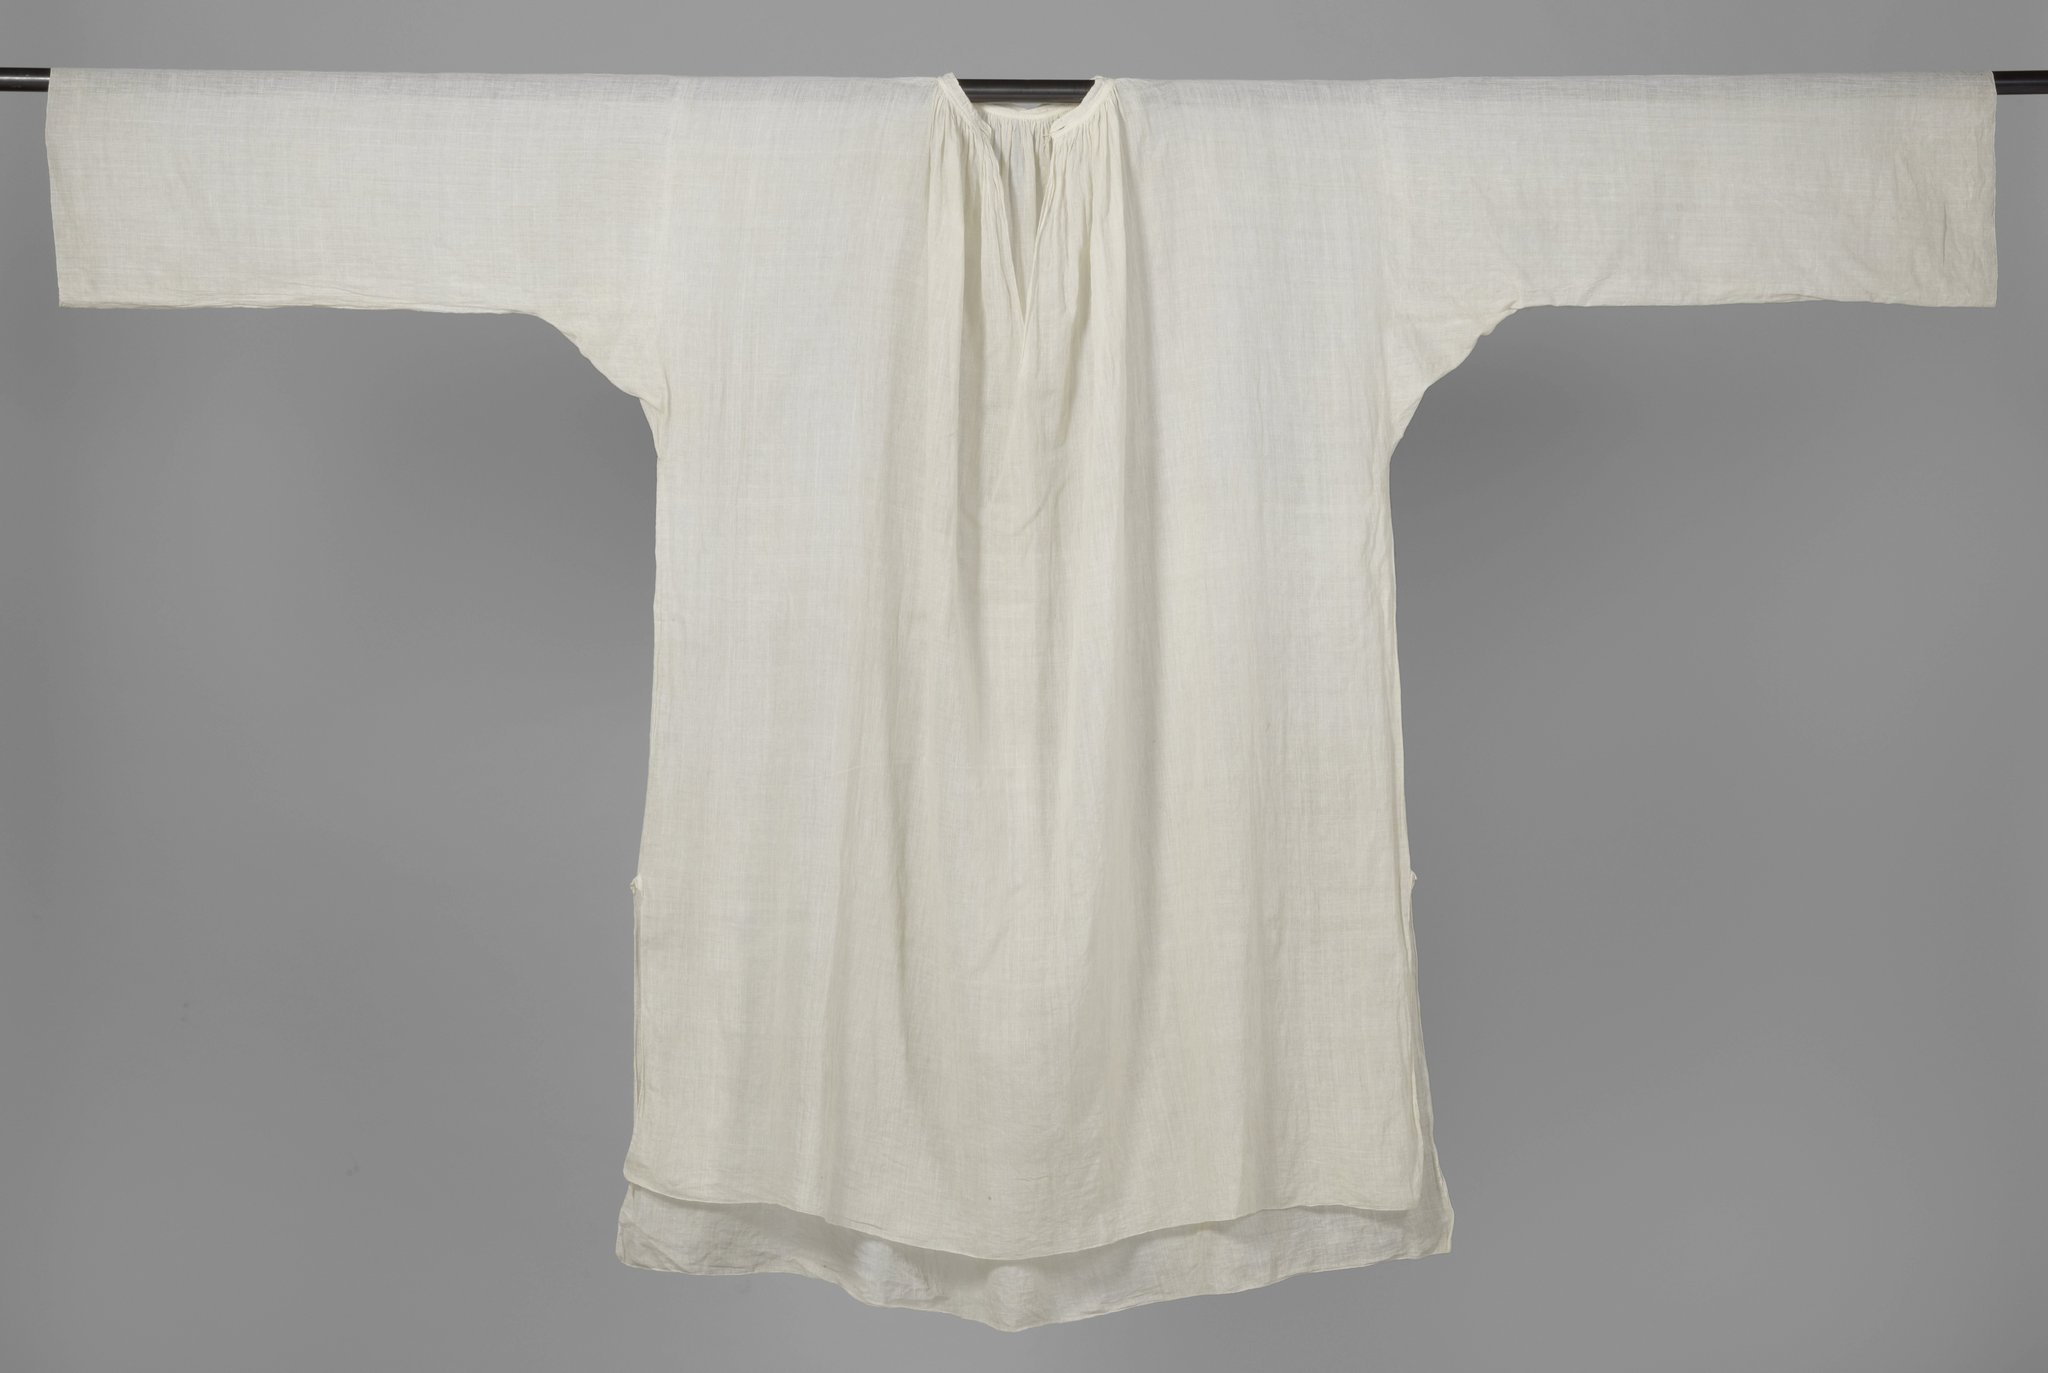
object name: menswear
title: Hemd zonder naad van katoenen batist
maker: Anonymous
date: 1600-1699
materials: cotton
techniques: weave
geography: netherlands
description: Hemd zonder naad van katoenen batist. Versierd met drie stiknaden. Mouwen eindigen in zeer fijn rolzoompje, dat ook aan de onderzijde is aangebracht. Ingeknipt halssplit met een T-vormig trensje verstevigd. Onderaan zijn zijsplitten ingeknipt. Voorpand korter dan achterpand, ca. 5 cm. Meegeweven spieën in oksel en schouder.